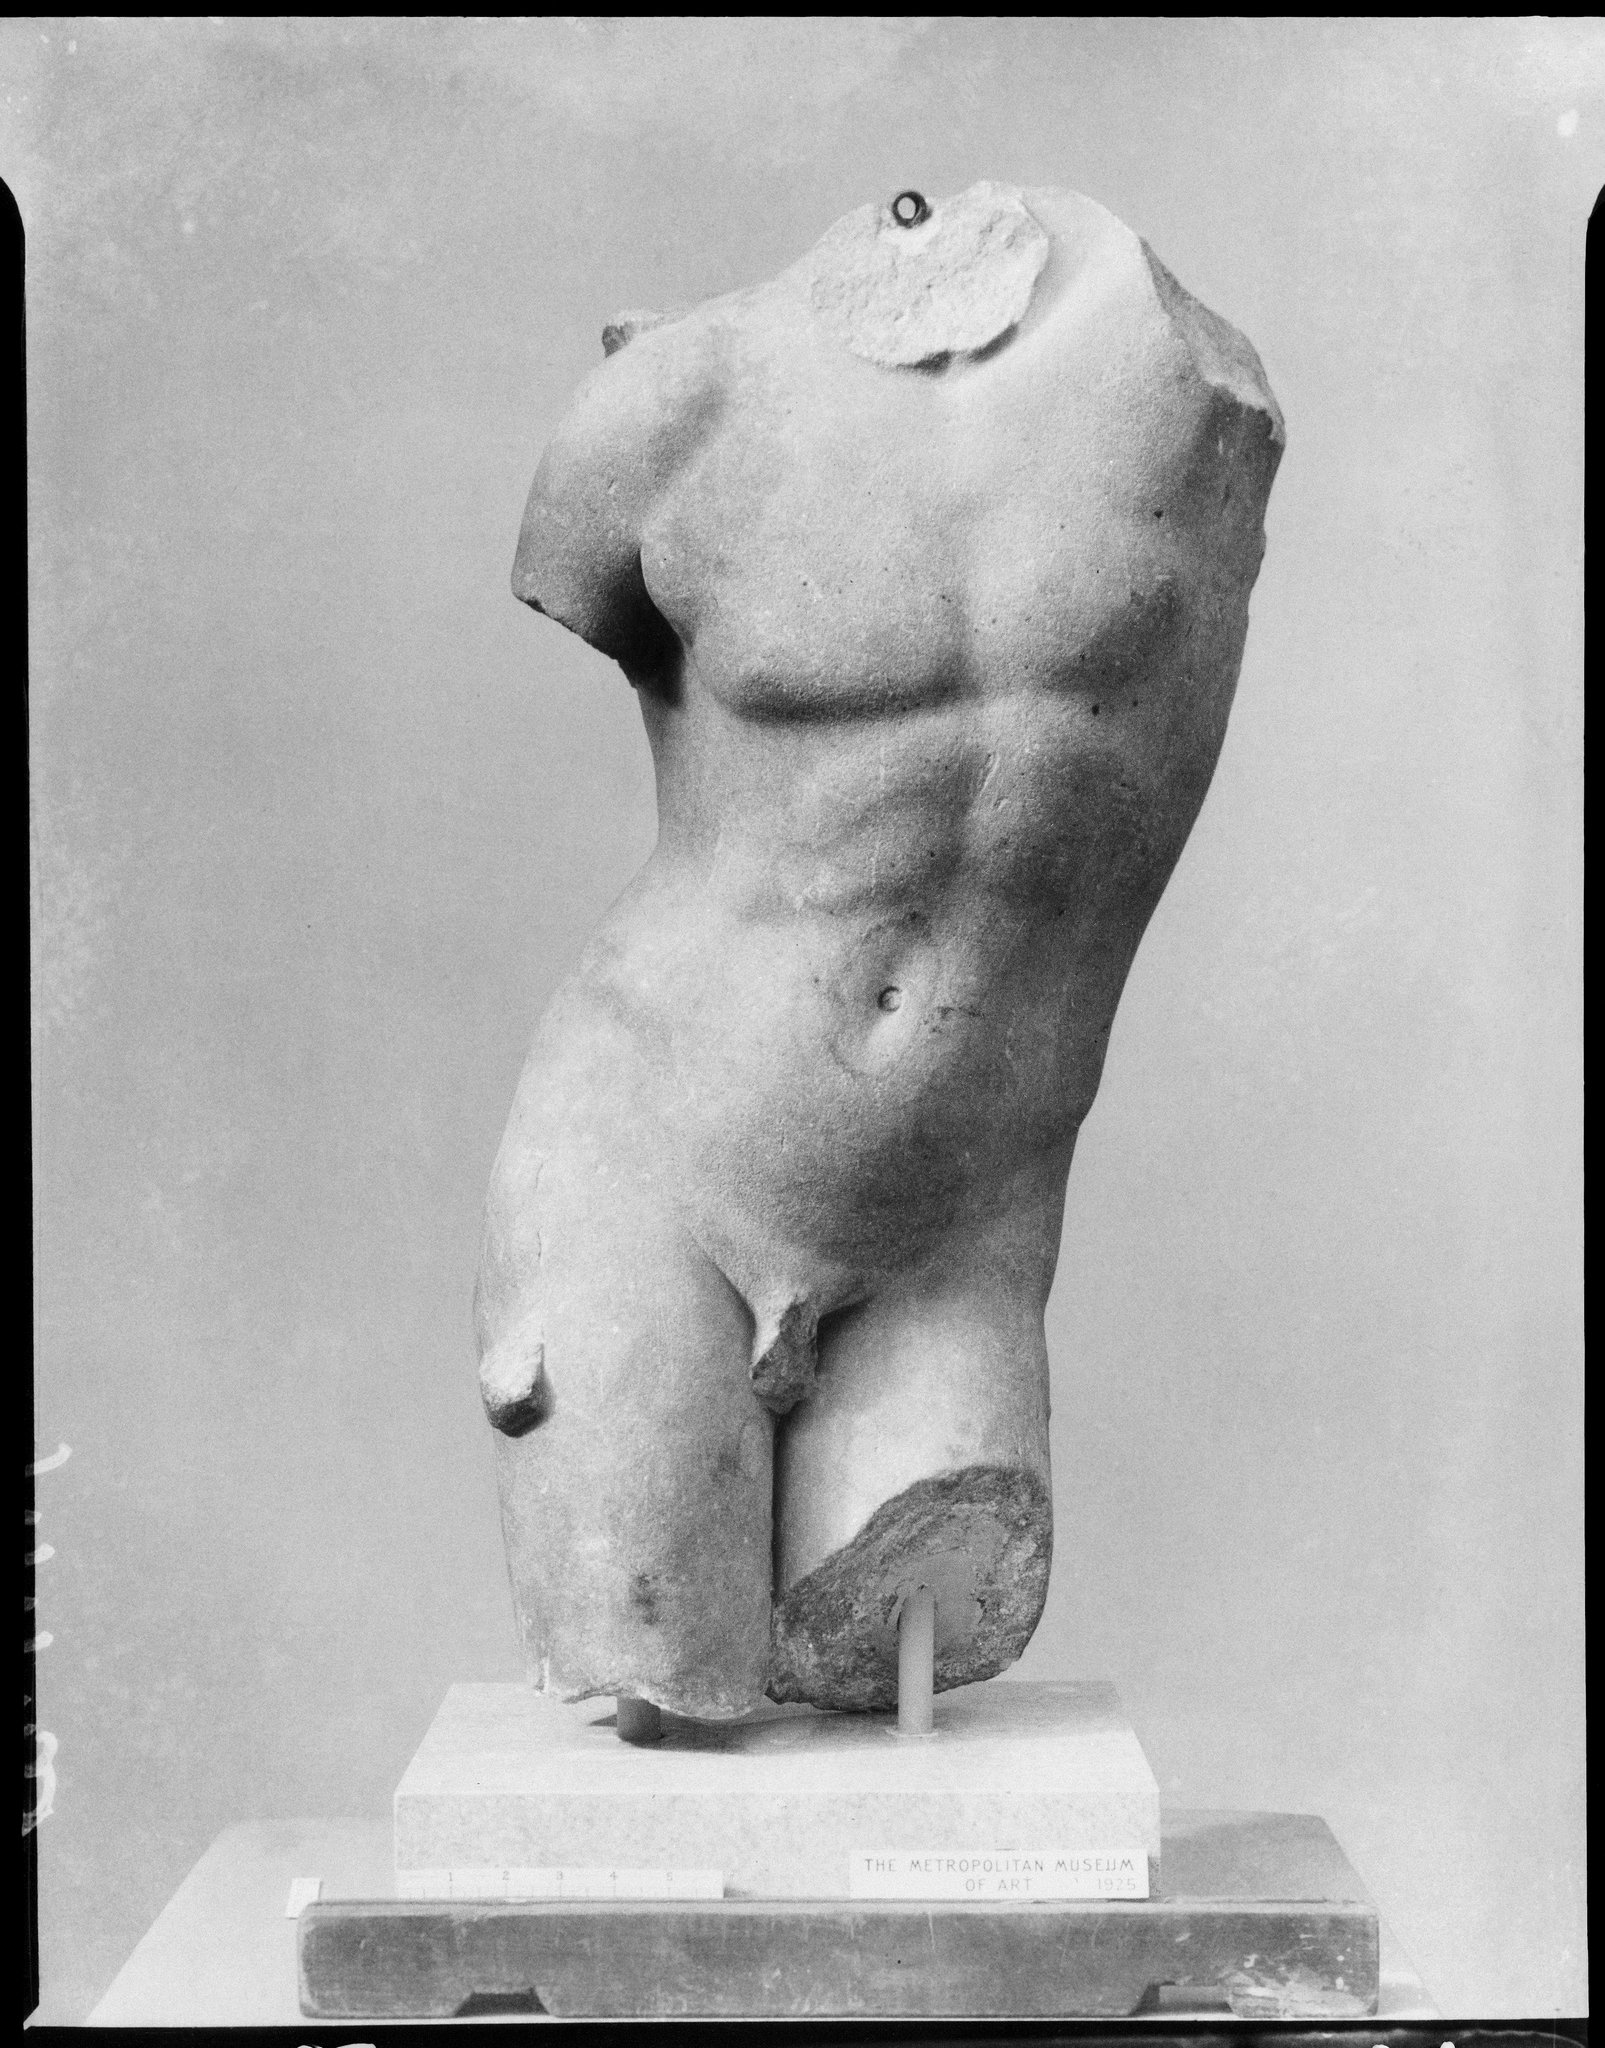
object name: statue of eros, fragmentary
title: Marble torso of Eros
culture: roman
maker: praxiteles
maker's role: artist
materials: marble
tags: eros